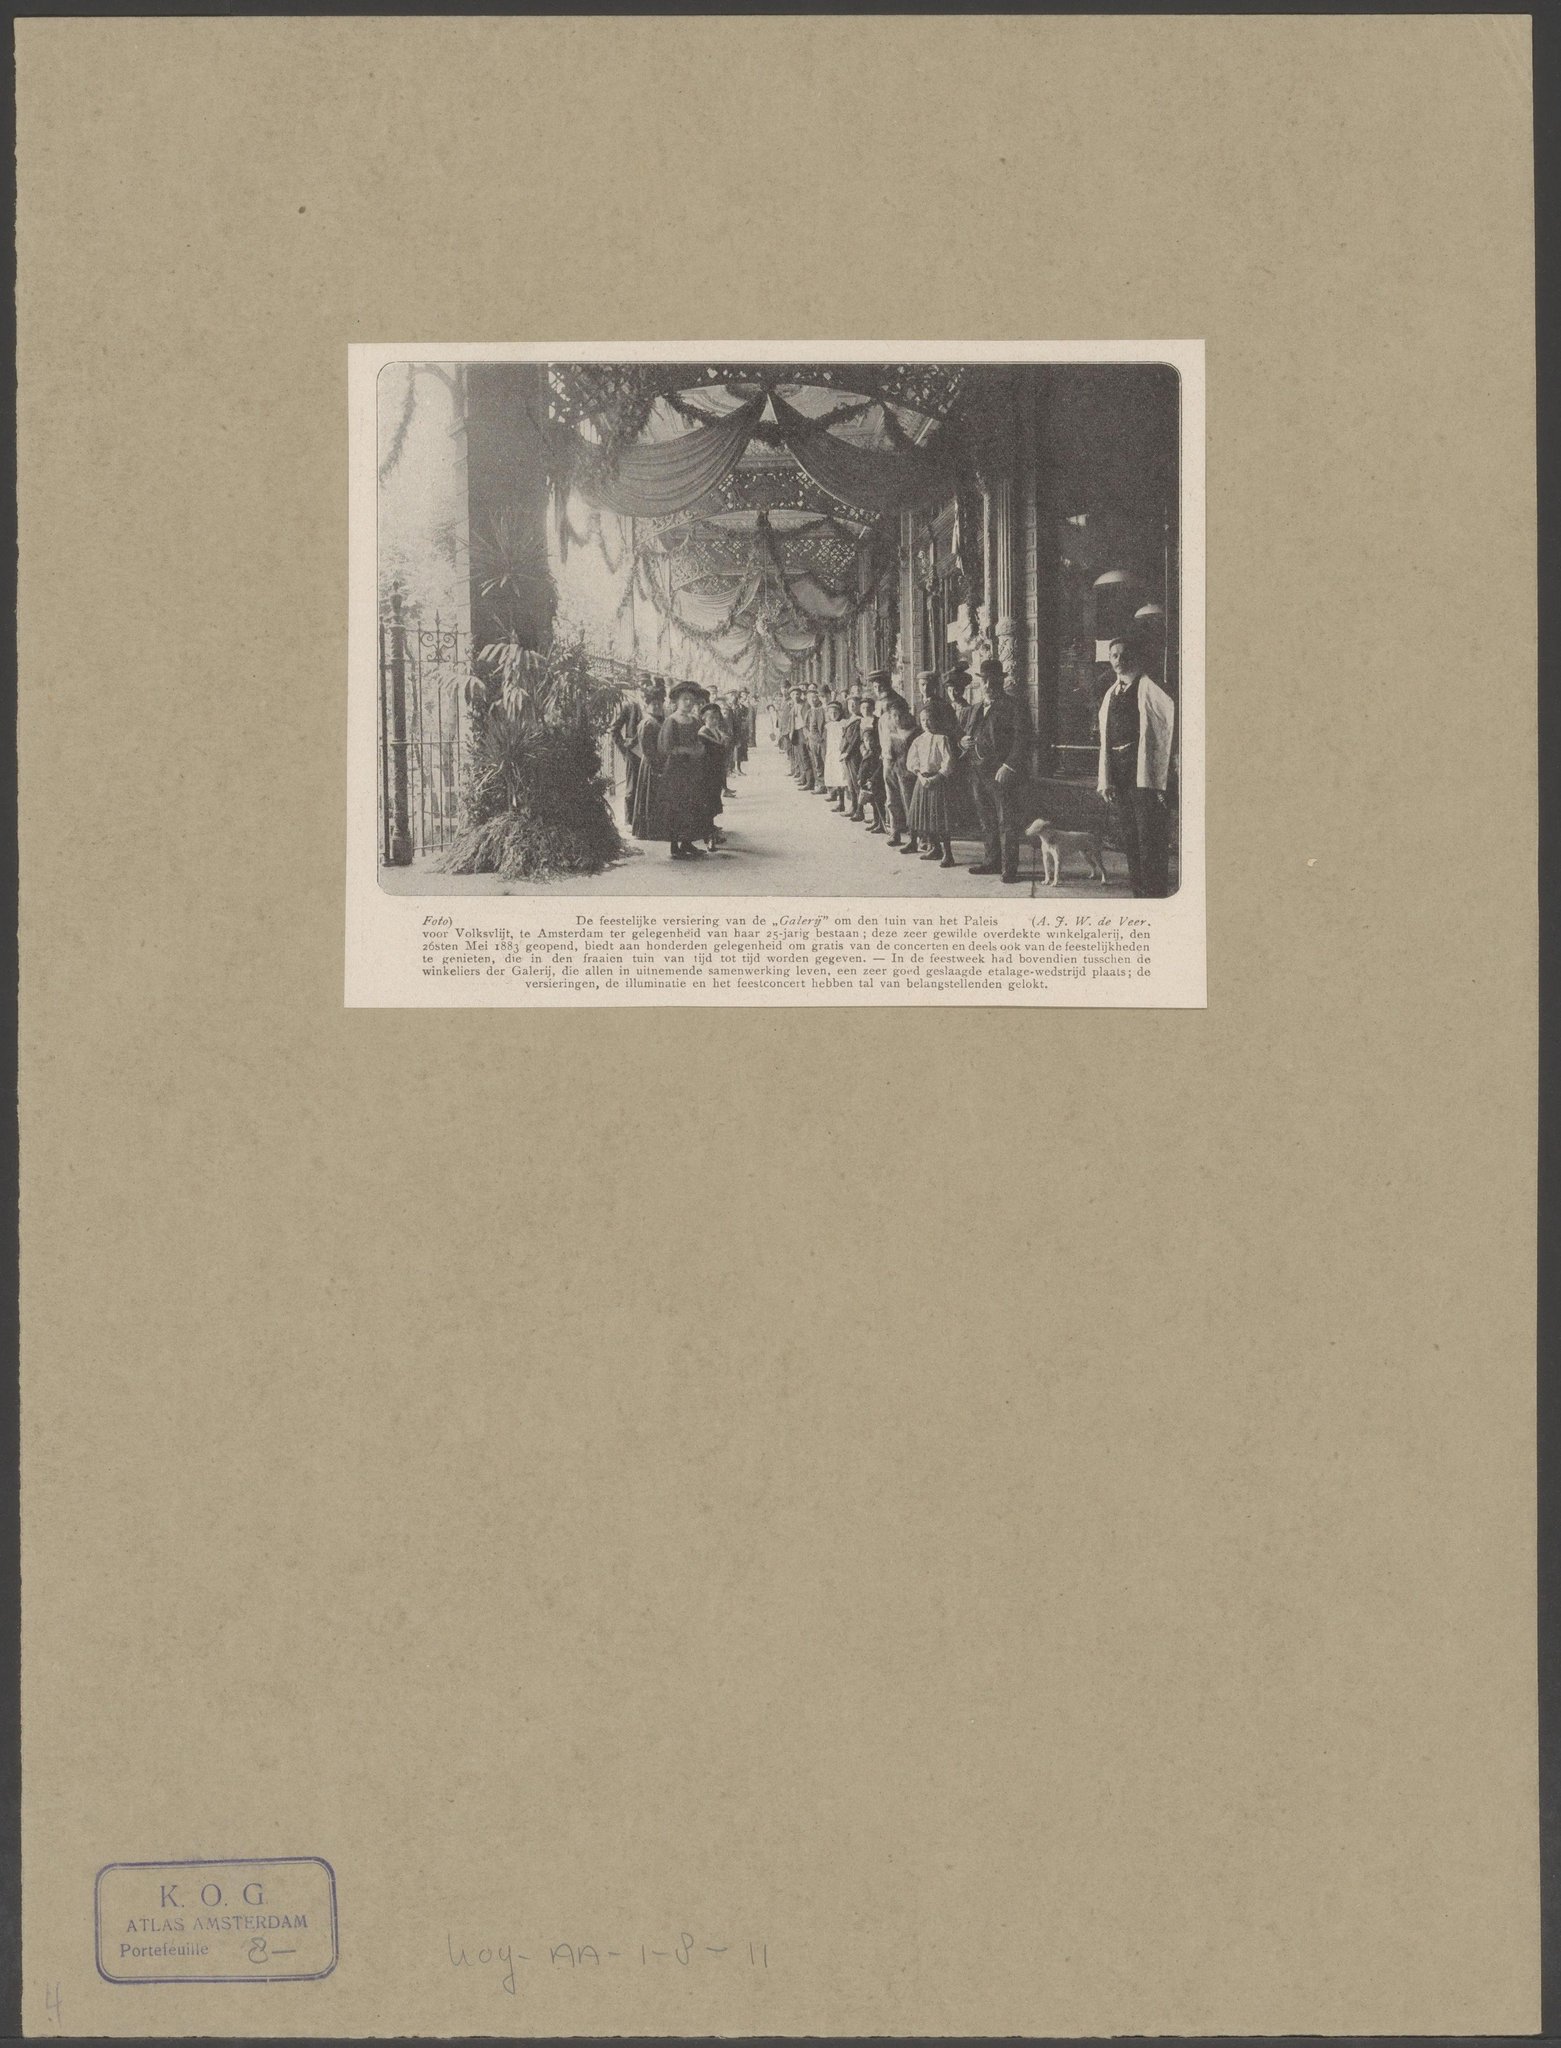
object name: photomechanical print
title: Gezicht op de versierde galerij van het Paleis voor Volksvlijt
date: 1889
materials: paper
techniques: letterpress printing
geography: amsterdam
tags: city-view in general; 'veduta', gallery (spacious corridor)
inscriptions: collector's mark: ‘8-’ Lugt 1641b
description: Onderwerpsrubriek binnen de Atlas Amsterdam: Galerij Paleis voor Volksvlijt, Gebed zonder end, Geldersche Kade, Gravenstraat, Grimburgwal, Grimnessesluis, Groeneburgwal.